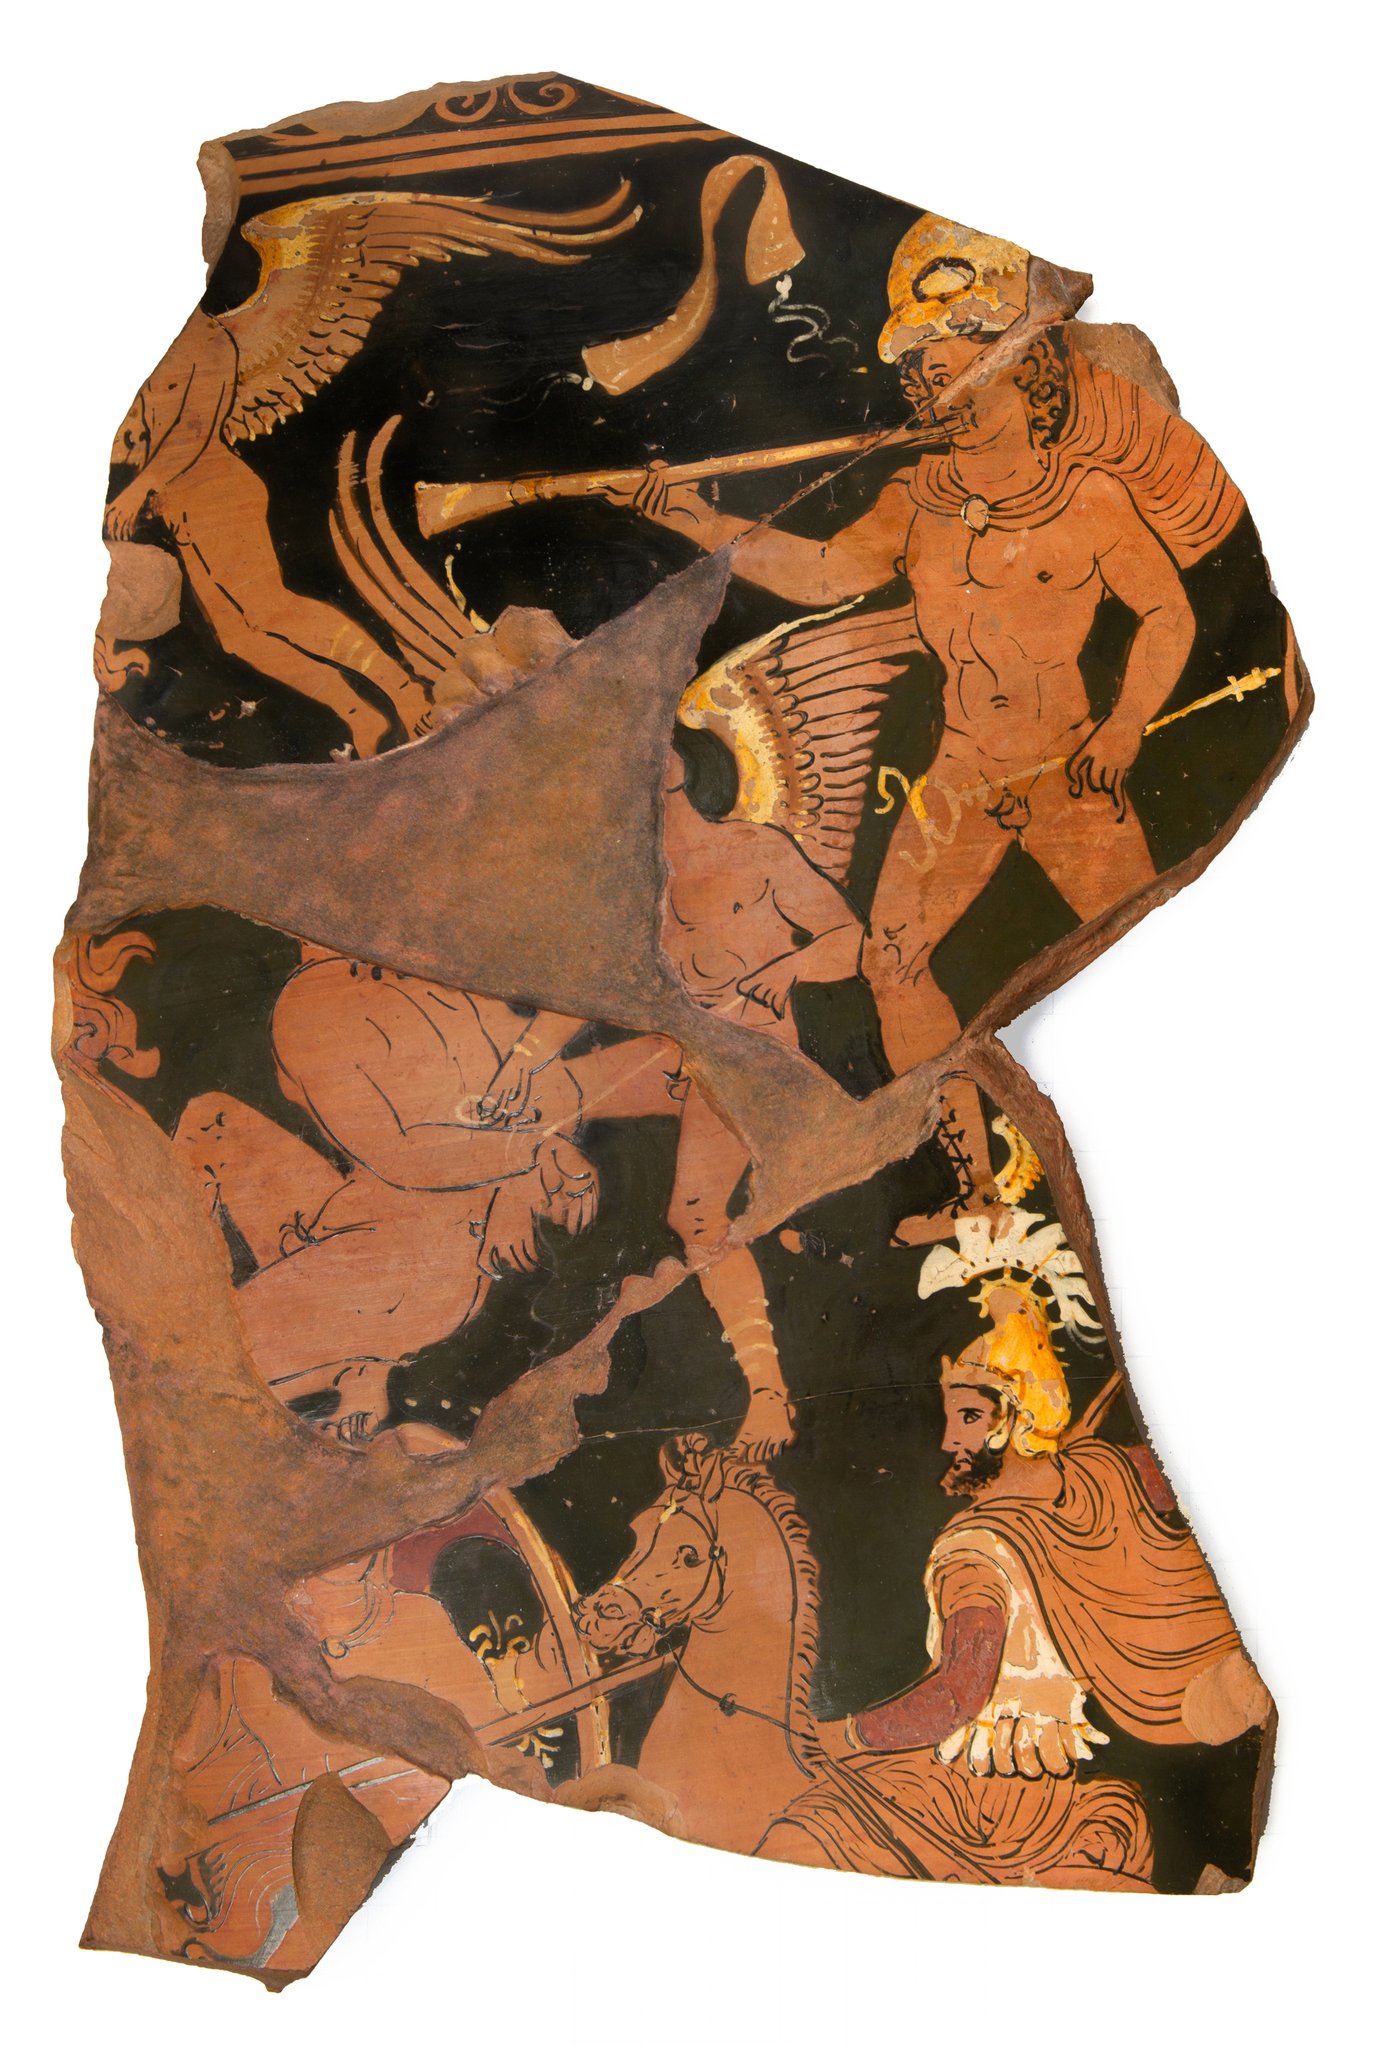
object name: volute krater fragment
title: Fragment of a terracotta volute-krater (bowl for mixing wine and water)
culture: greek, south italian, apulian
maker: baltimore painter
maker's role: artist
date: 325-301 BCE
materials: terracotta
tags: male nudes,horses,warriors